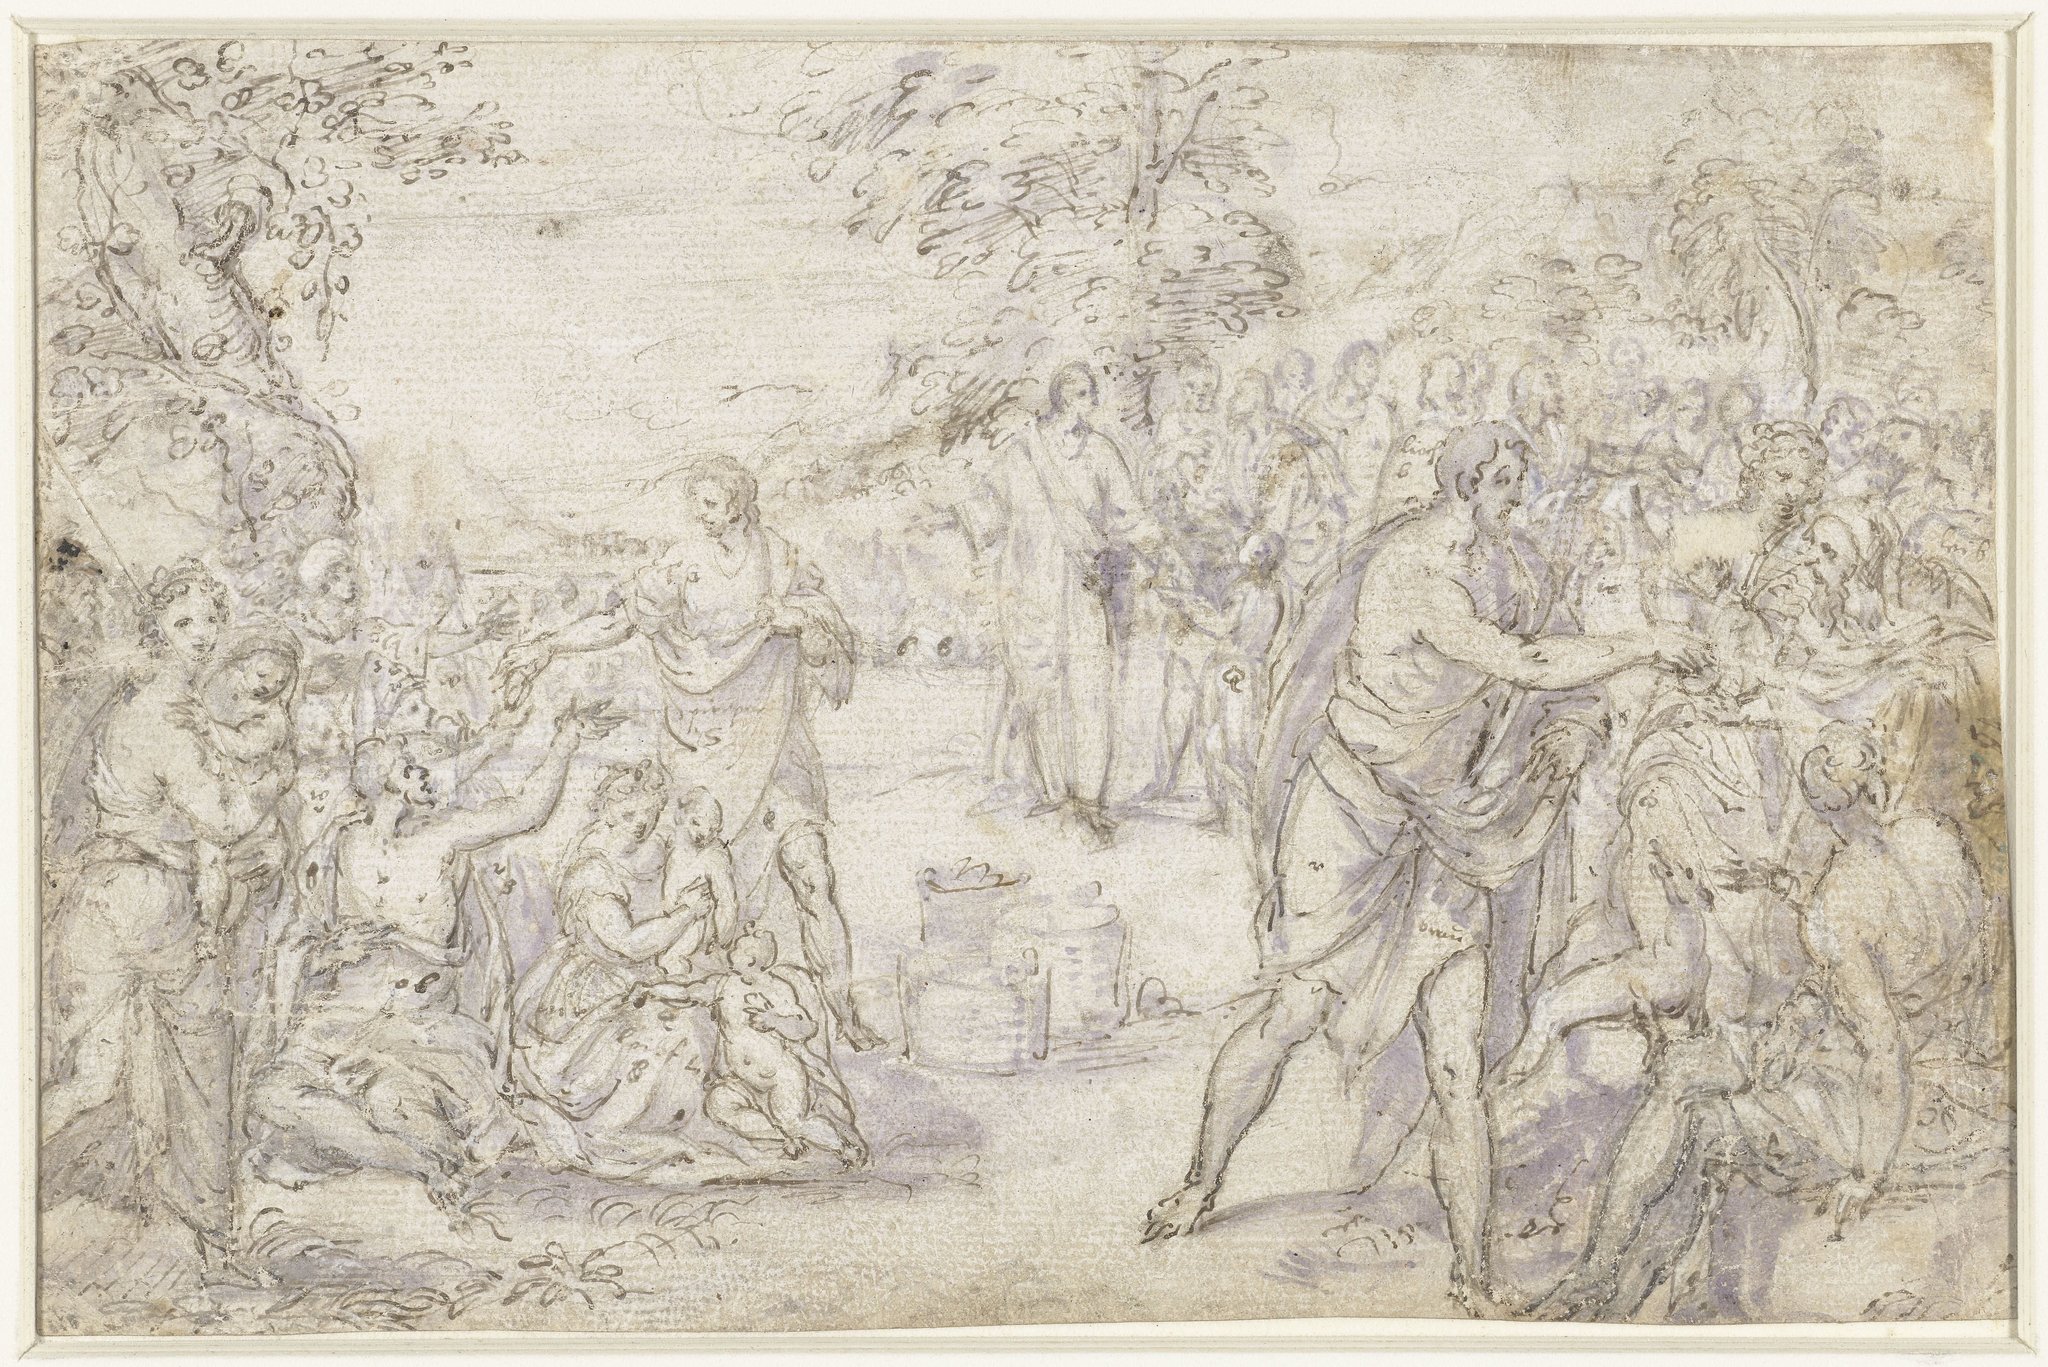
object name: drawing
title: Vermenigvuldiging der broden door Christus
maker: christoph schwarz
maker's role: draughtsman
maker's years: 1545-1592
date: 1555-1592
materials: ink, paper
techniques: brush, pen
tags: christ and apostles distribute bread and fish among the multitude